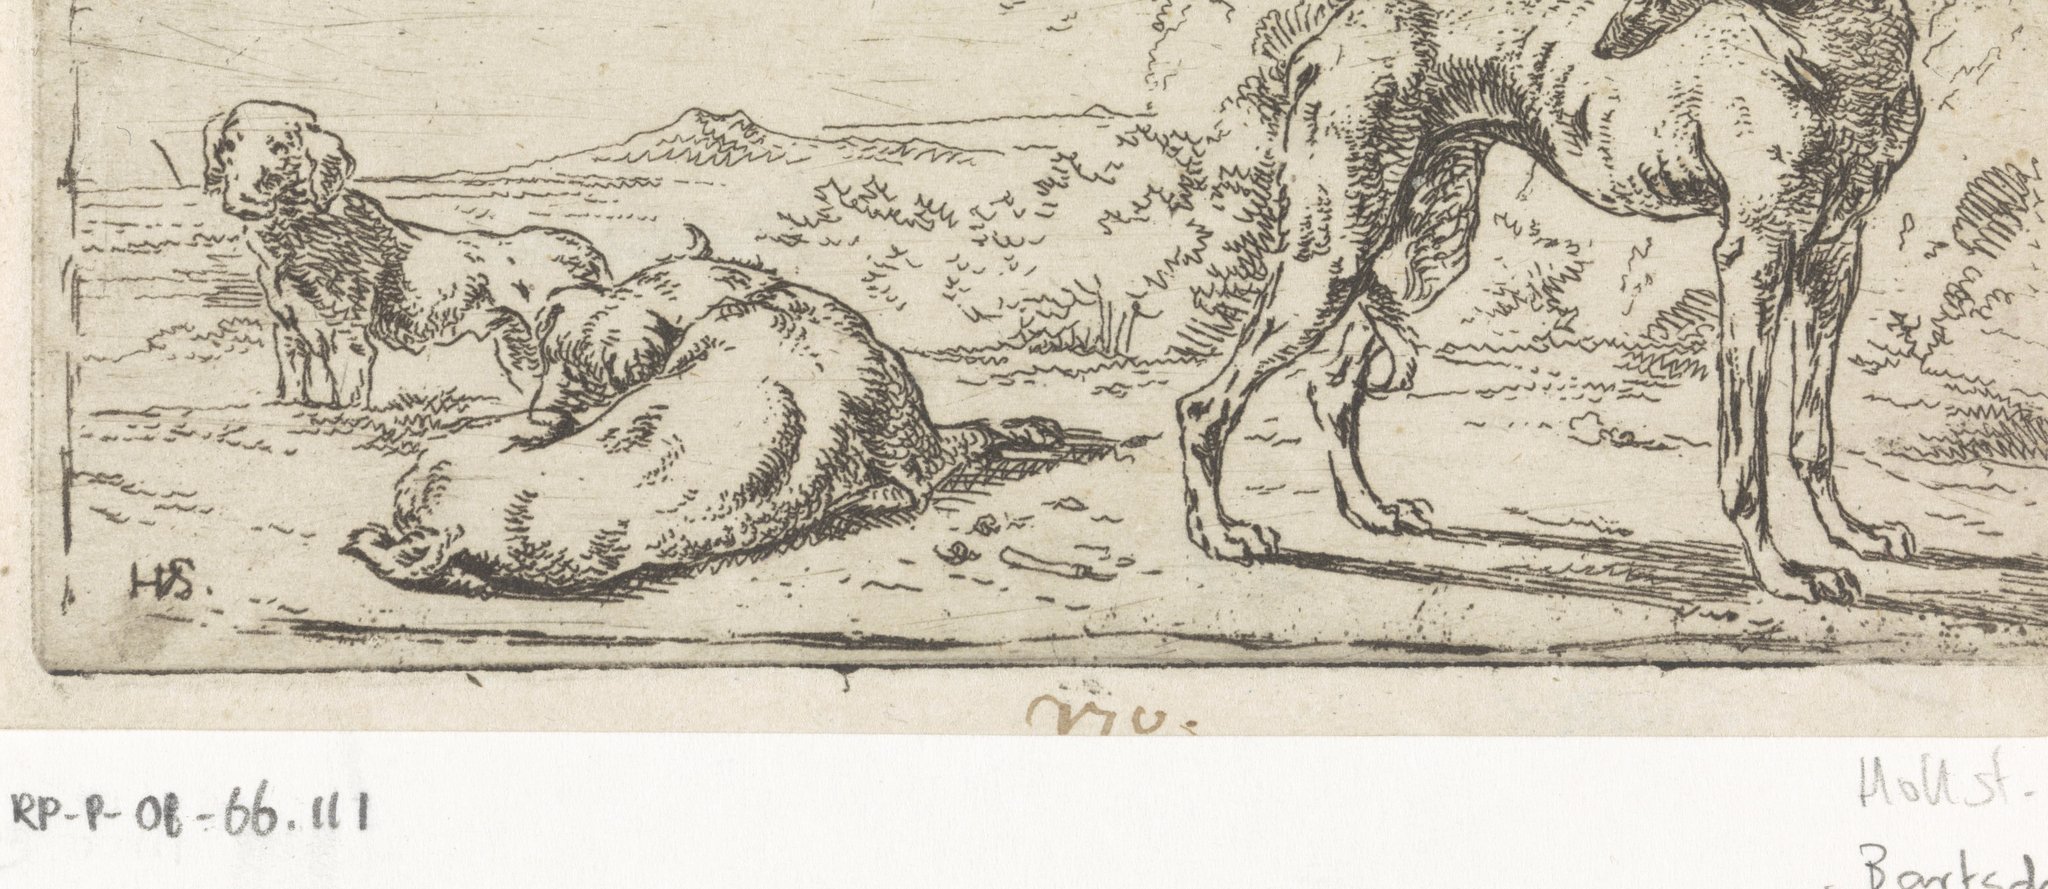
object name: print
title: Drie honden in een landschap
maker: hendrik verschuring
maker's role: draughtsman, print maker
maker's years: 1627-1690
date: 1635-1690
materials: paper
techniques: etching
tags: dog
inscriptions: collector's mark: Lugt 12, collector's mark: ‘F. Rechberger 1800’ Lugt 2133